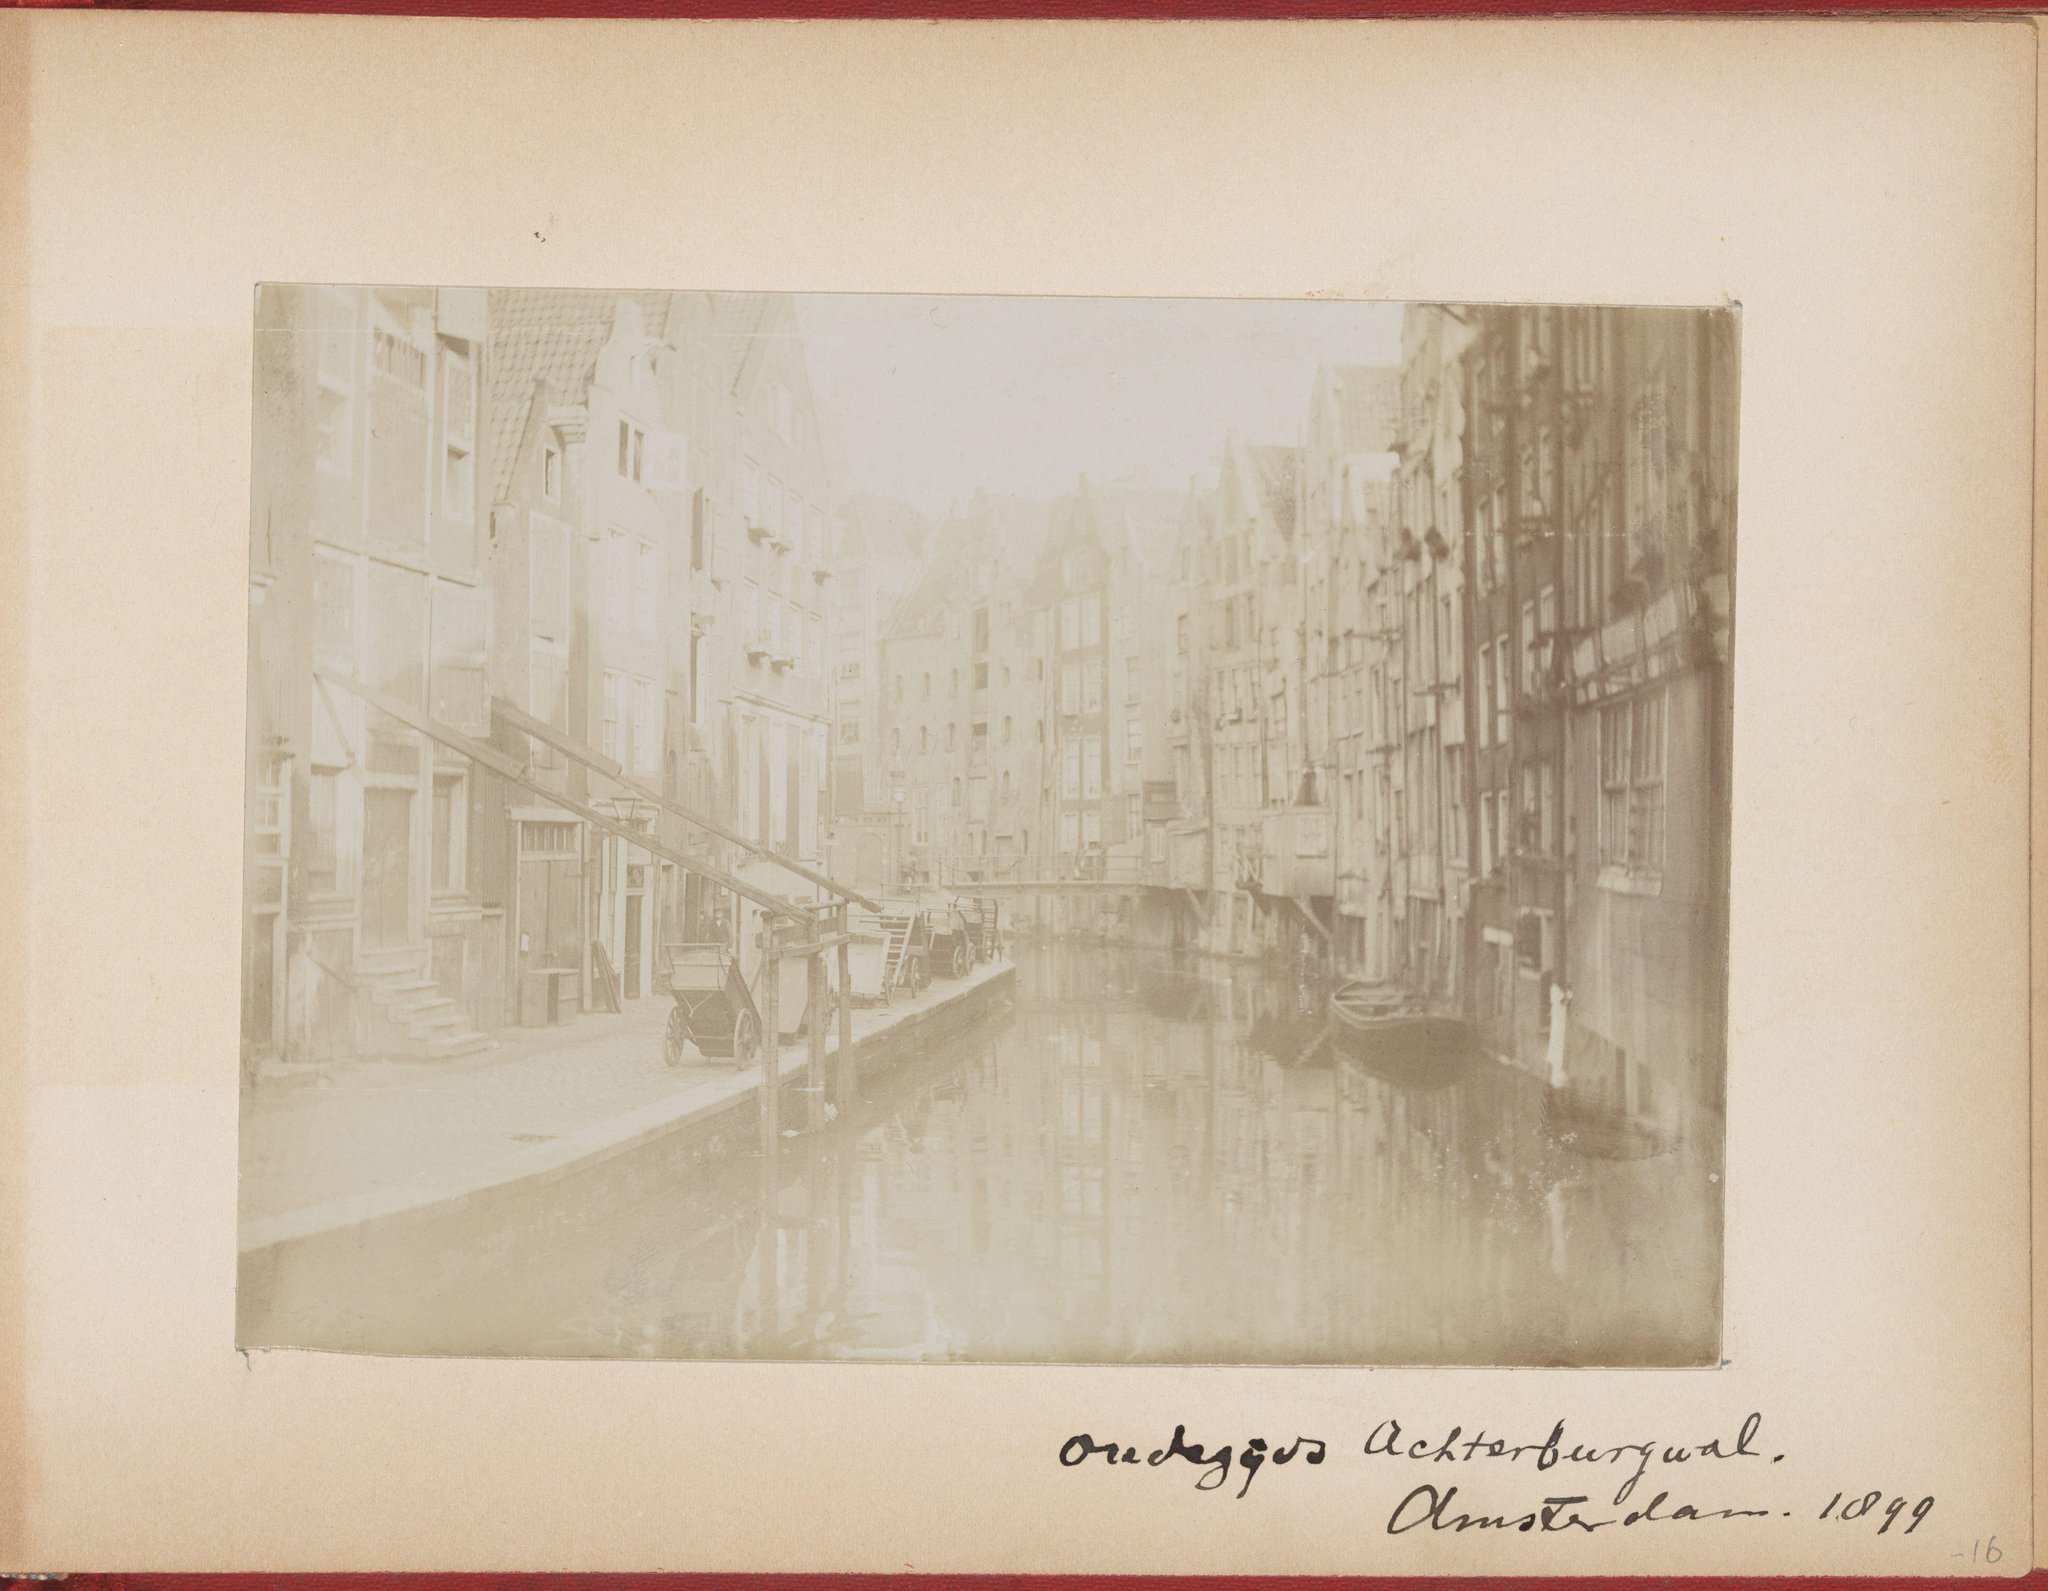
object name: photograph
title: Oudezijds Achterburgwal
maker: gerard aalbersberg (us)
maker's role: amateurfotograaf, arts, chirurg, gynaecoloog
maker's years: 1870-1934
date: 1899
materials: paper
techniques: gelatin silver print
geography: amsterdam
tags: oudezijds achterburgwal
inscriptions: title: ‘Oudezijds Achterburgwal Amsterdam 1899’